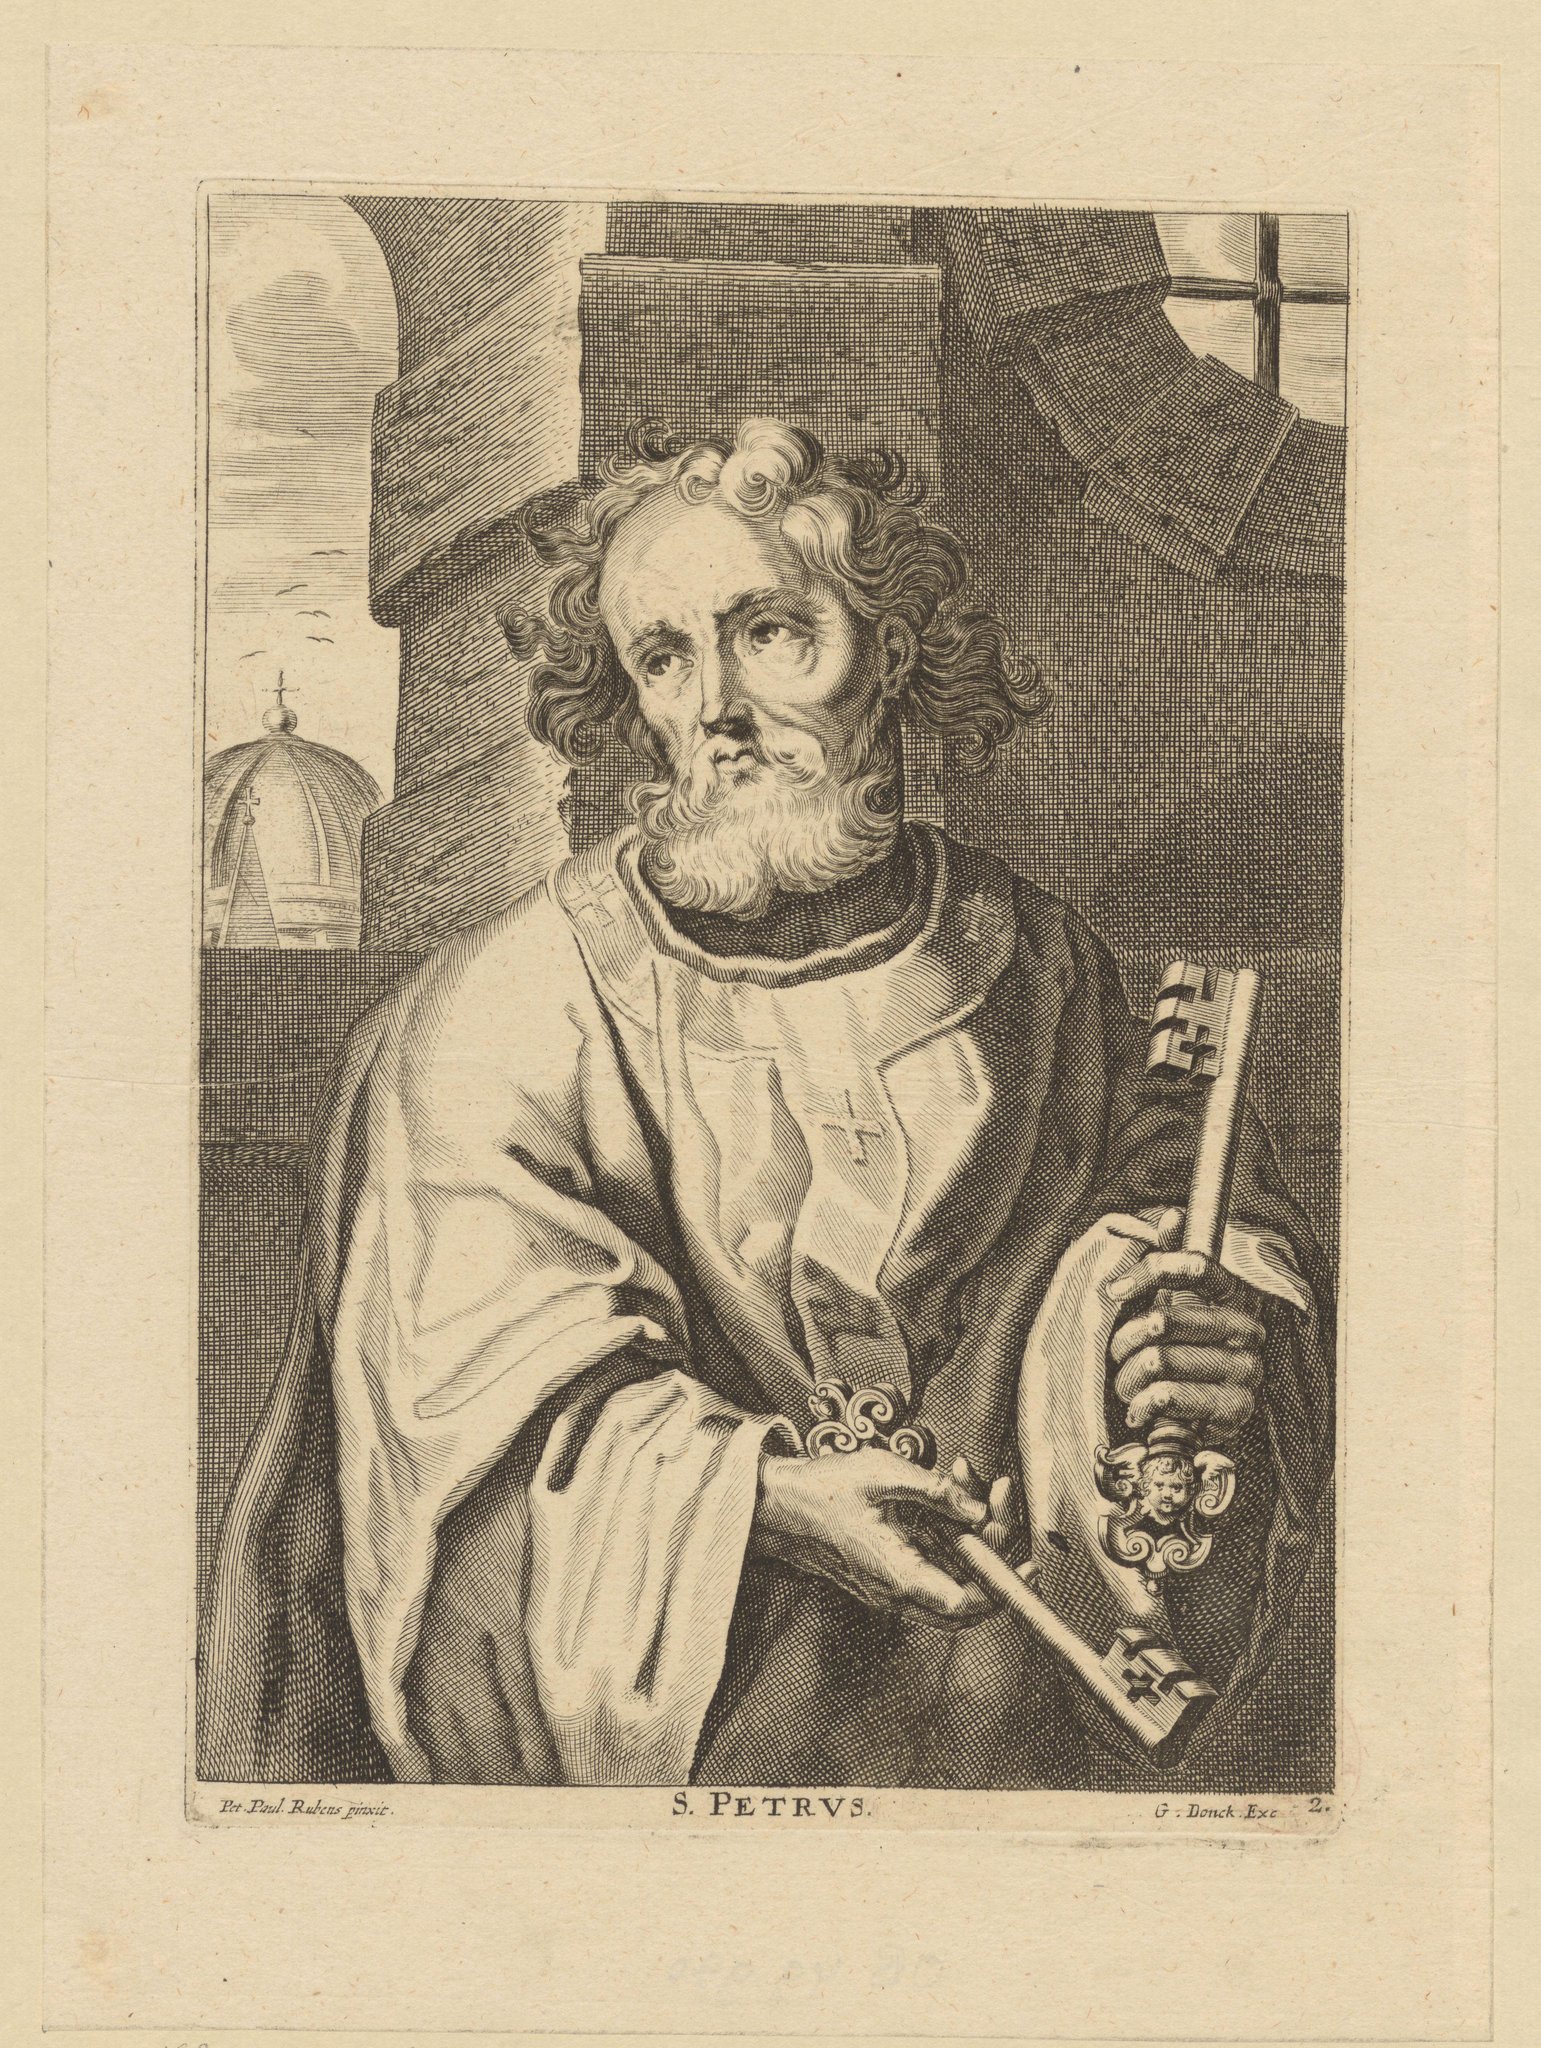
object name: print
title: H. Petrus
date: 1611-1612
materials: paper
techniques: engraving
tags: the apostle peter, first bishop of rome; possible attributes: book, cock, (upturned) cross, (triple) crozier, fish, key, scroll, ship, tiara